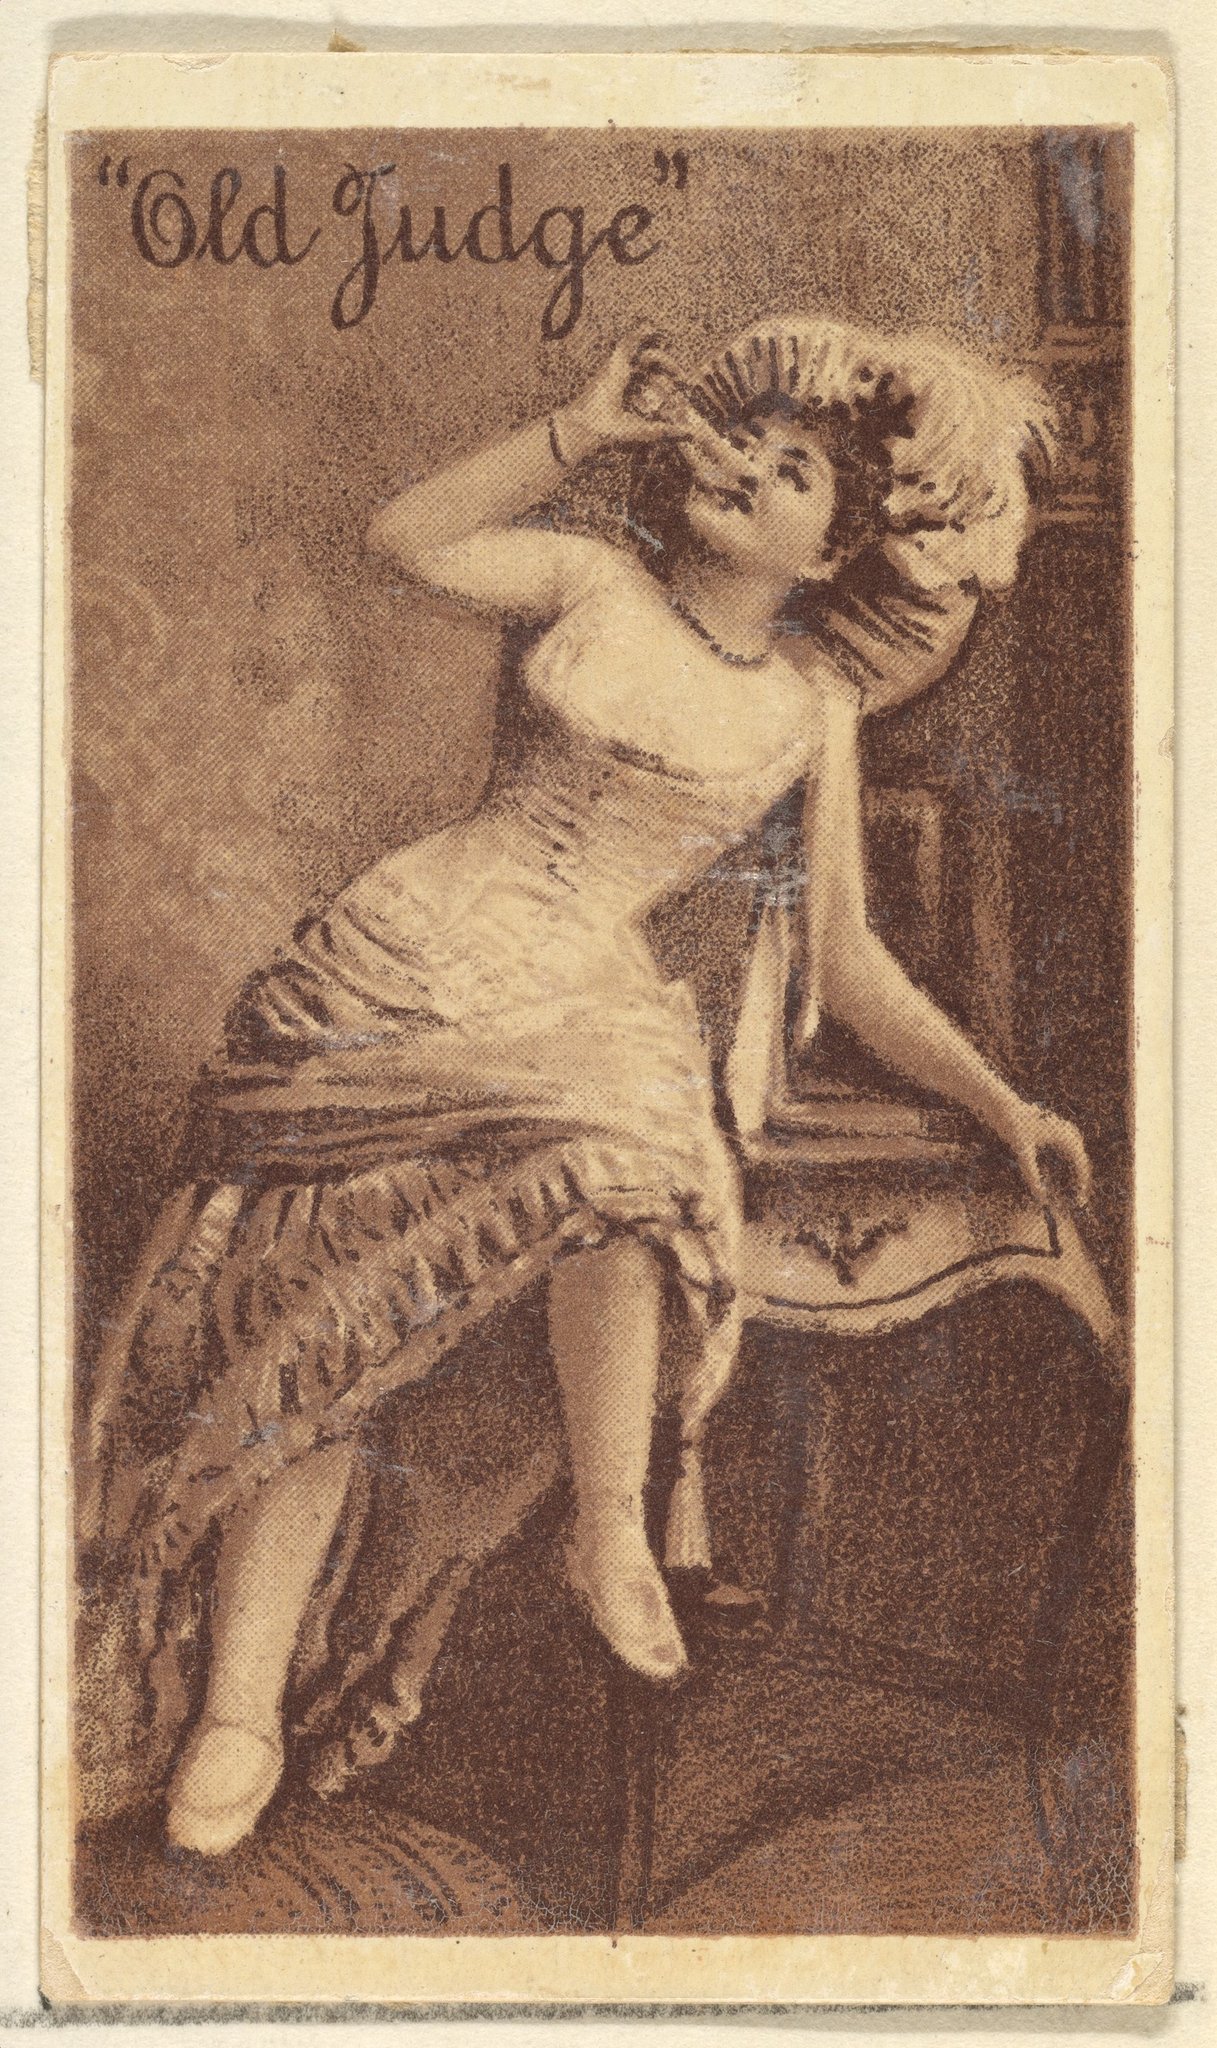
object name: print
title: Actress from the Old Judge series (N167) for Old Judge Cigarettes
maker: goodwin & company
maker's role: publisher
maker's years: 1850-1950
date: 1886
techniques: lithography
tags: portraits,women